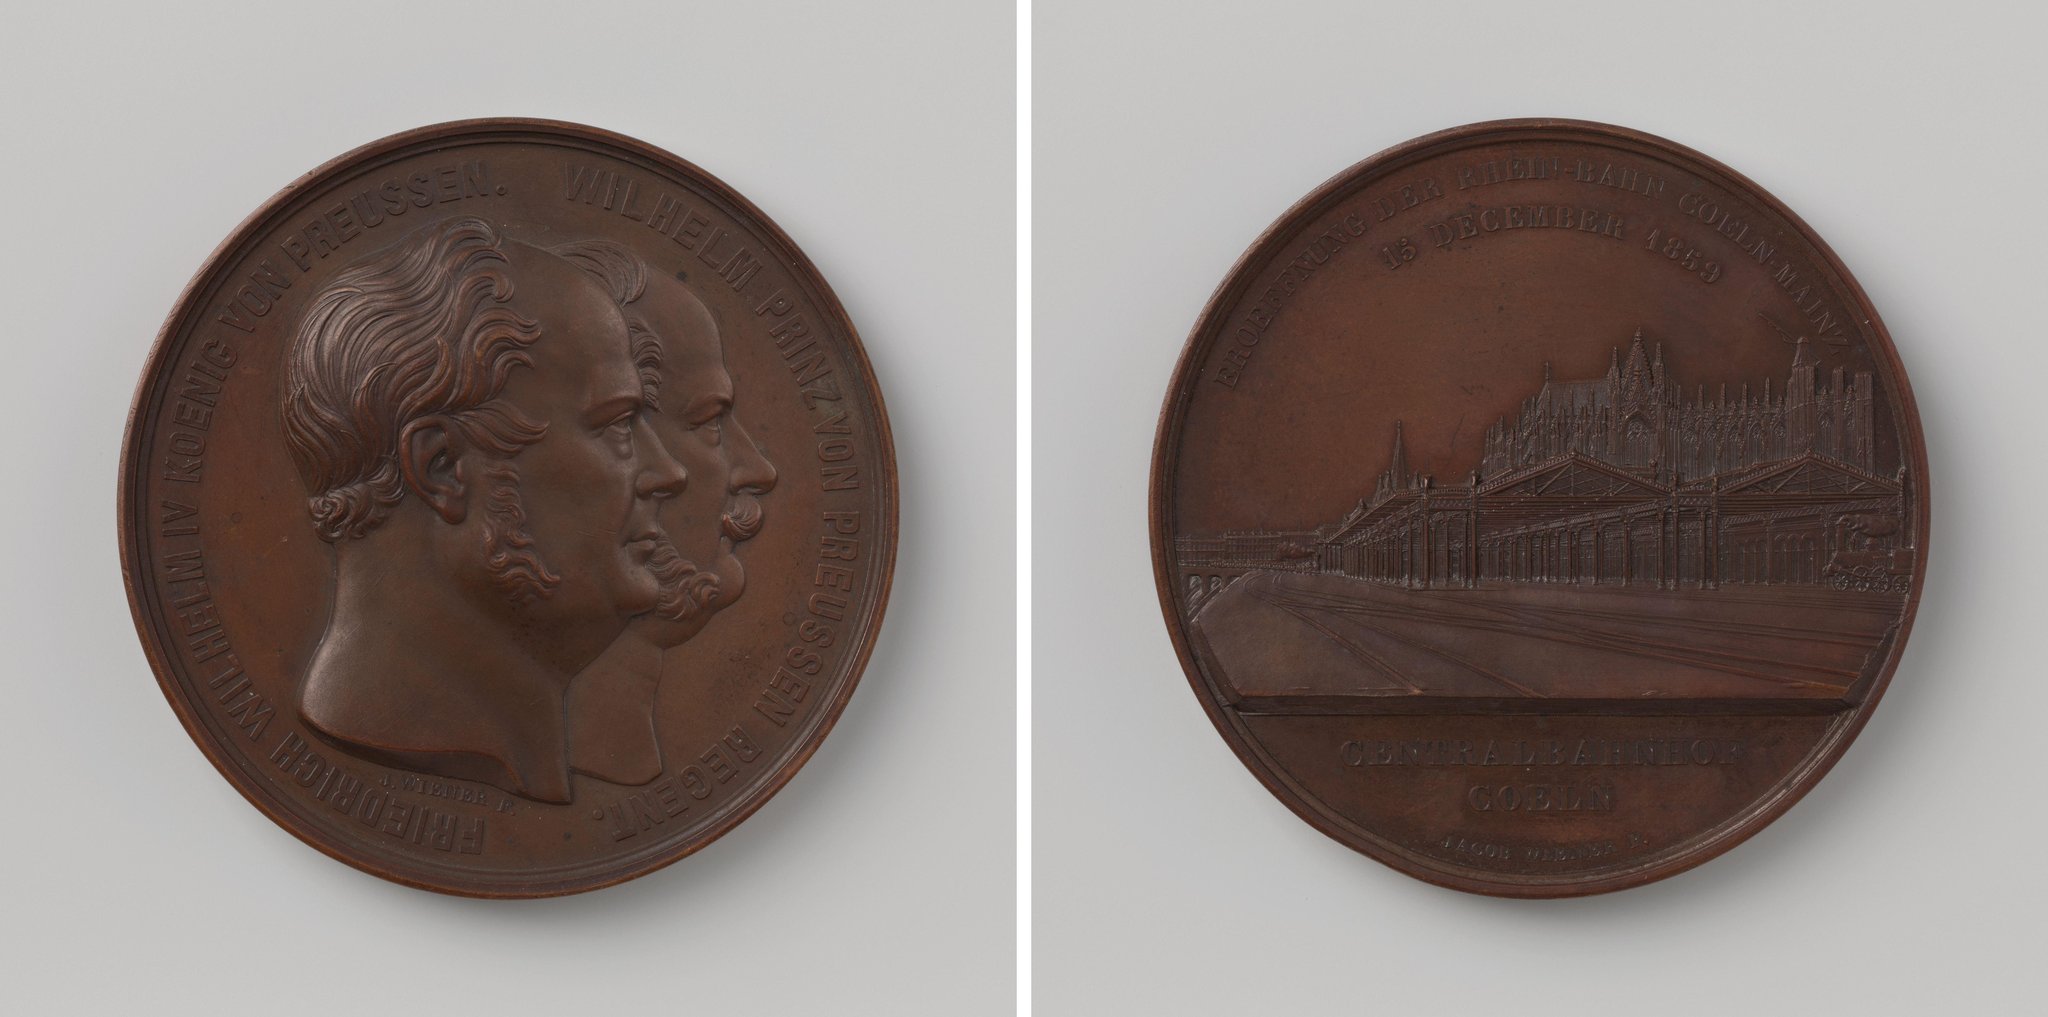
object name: history medal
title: Opening van de Rheinbahn Keulen-Mainz, ter ere van Frederik Willem IV, koning van Pruisen en Willem, regent van Pruisen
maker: jacob wiener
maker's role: medailleur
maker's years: 1815-1899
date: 1859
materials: bronze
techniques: striking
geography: brussels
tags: frederik willem iv (koning van pruisen), berlin, wilhelm i (keizer van duitsland), cologne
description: Bronzen penning. Voorzijde: borststukken van twee mannen binnen omschrift. Keerzijde: station van Keulen voor nog niet geheel voltooide Dom binnen omschrift; afsnede: opschrift